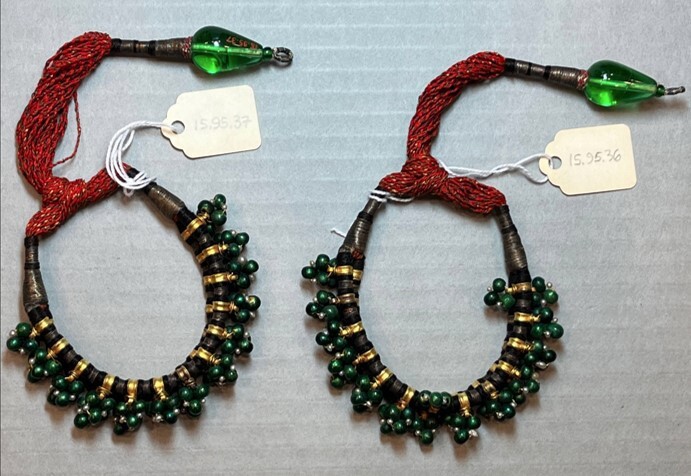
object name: bracelet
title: Bracelet (Bazuband), One of a Pair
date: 1701-1900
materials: gold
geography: india